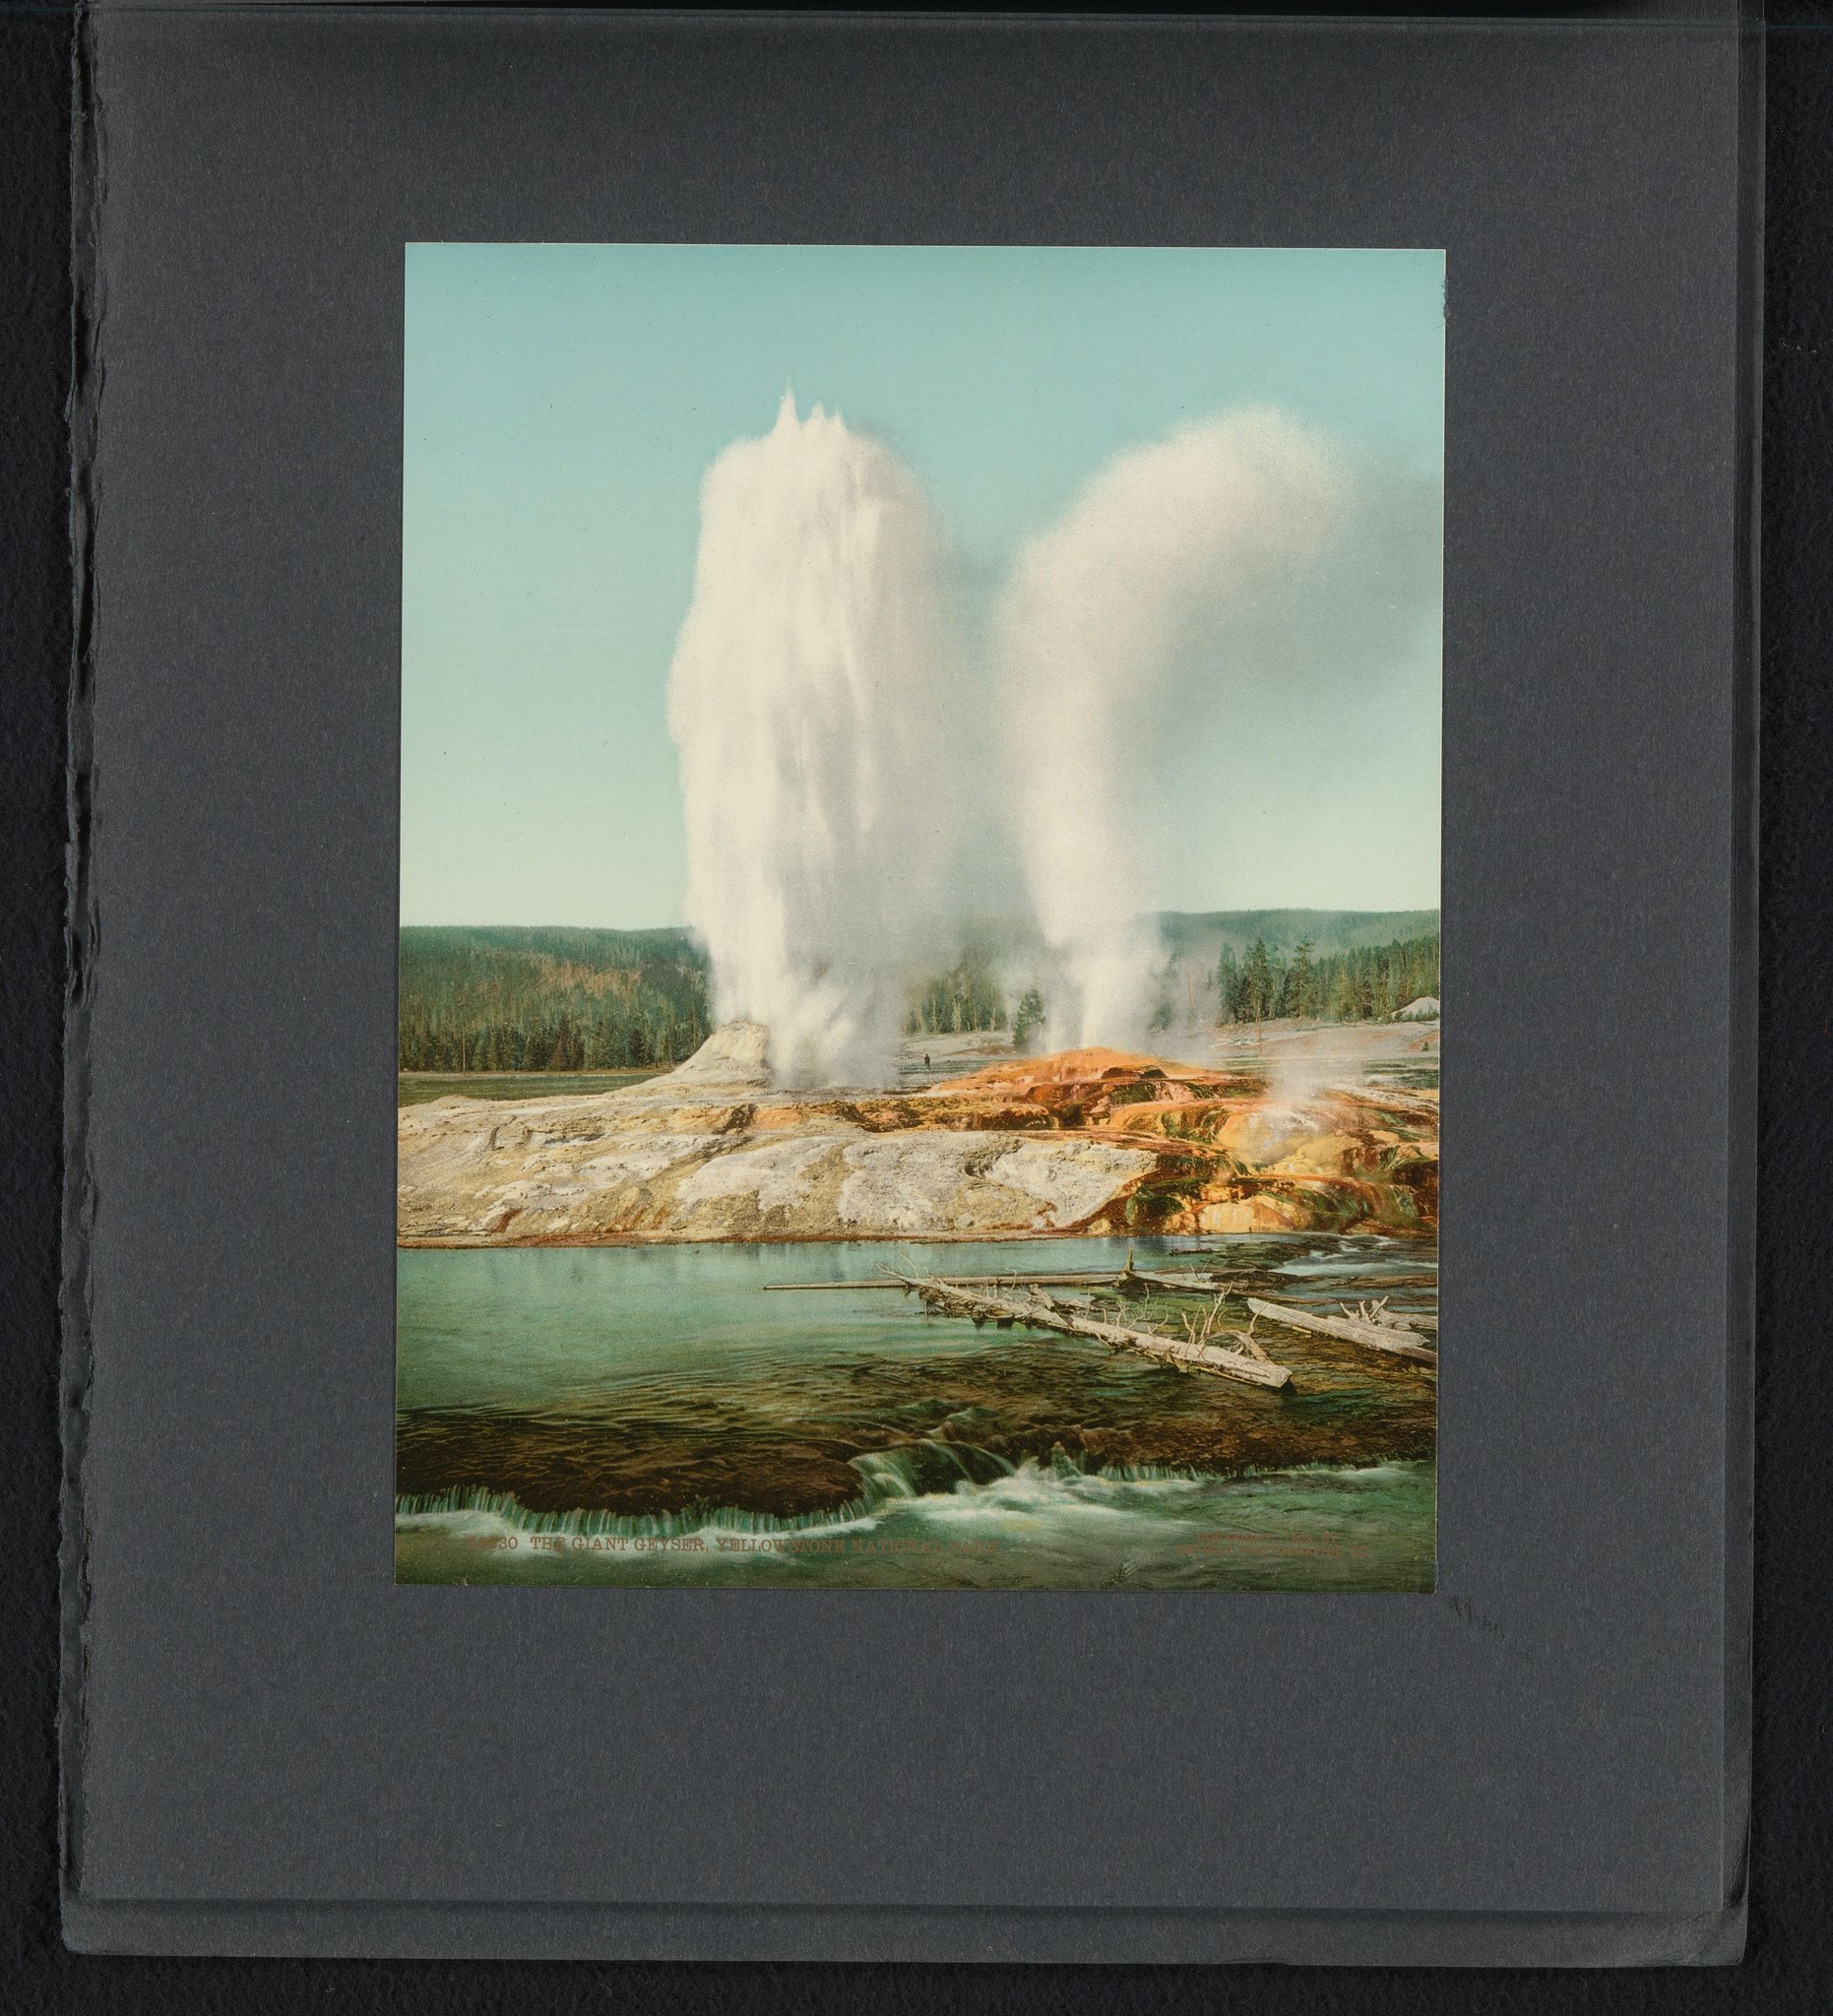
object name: photomechanical print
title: Gezicht op een uitbarstende Giant Geyser in Yellowstone National Park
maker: william henry jackson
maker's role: fotograaf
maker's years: 1843-1942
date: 1902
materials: paper, photographic process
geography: yellowstone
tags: steam, hot spring, geyser, trees: pine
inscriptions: inscription: ‘53330/ COPYRIGHT, 1902, BY/ DETROIT PHOTOGRAPHIC CO.’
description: Prent op drieëntwintigste ongenummerde pagina.